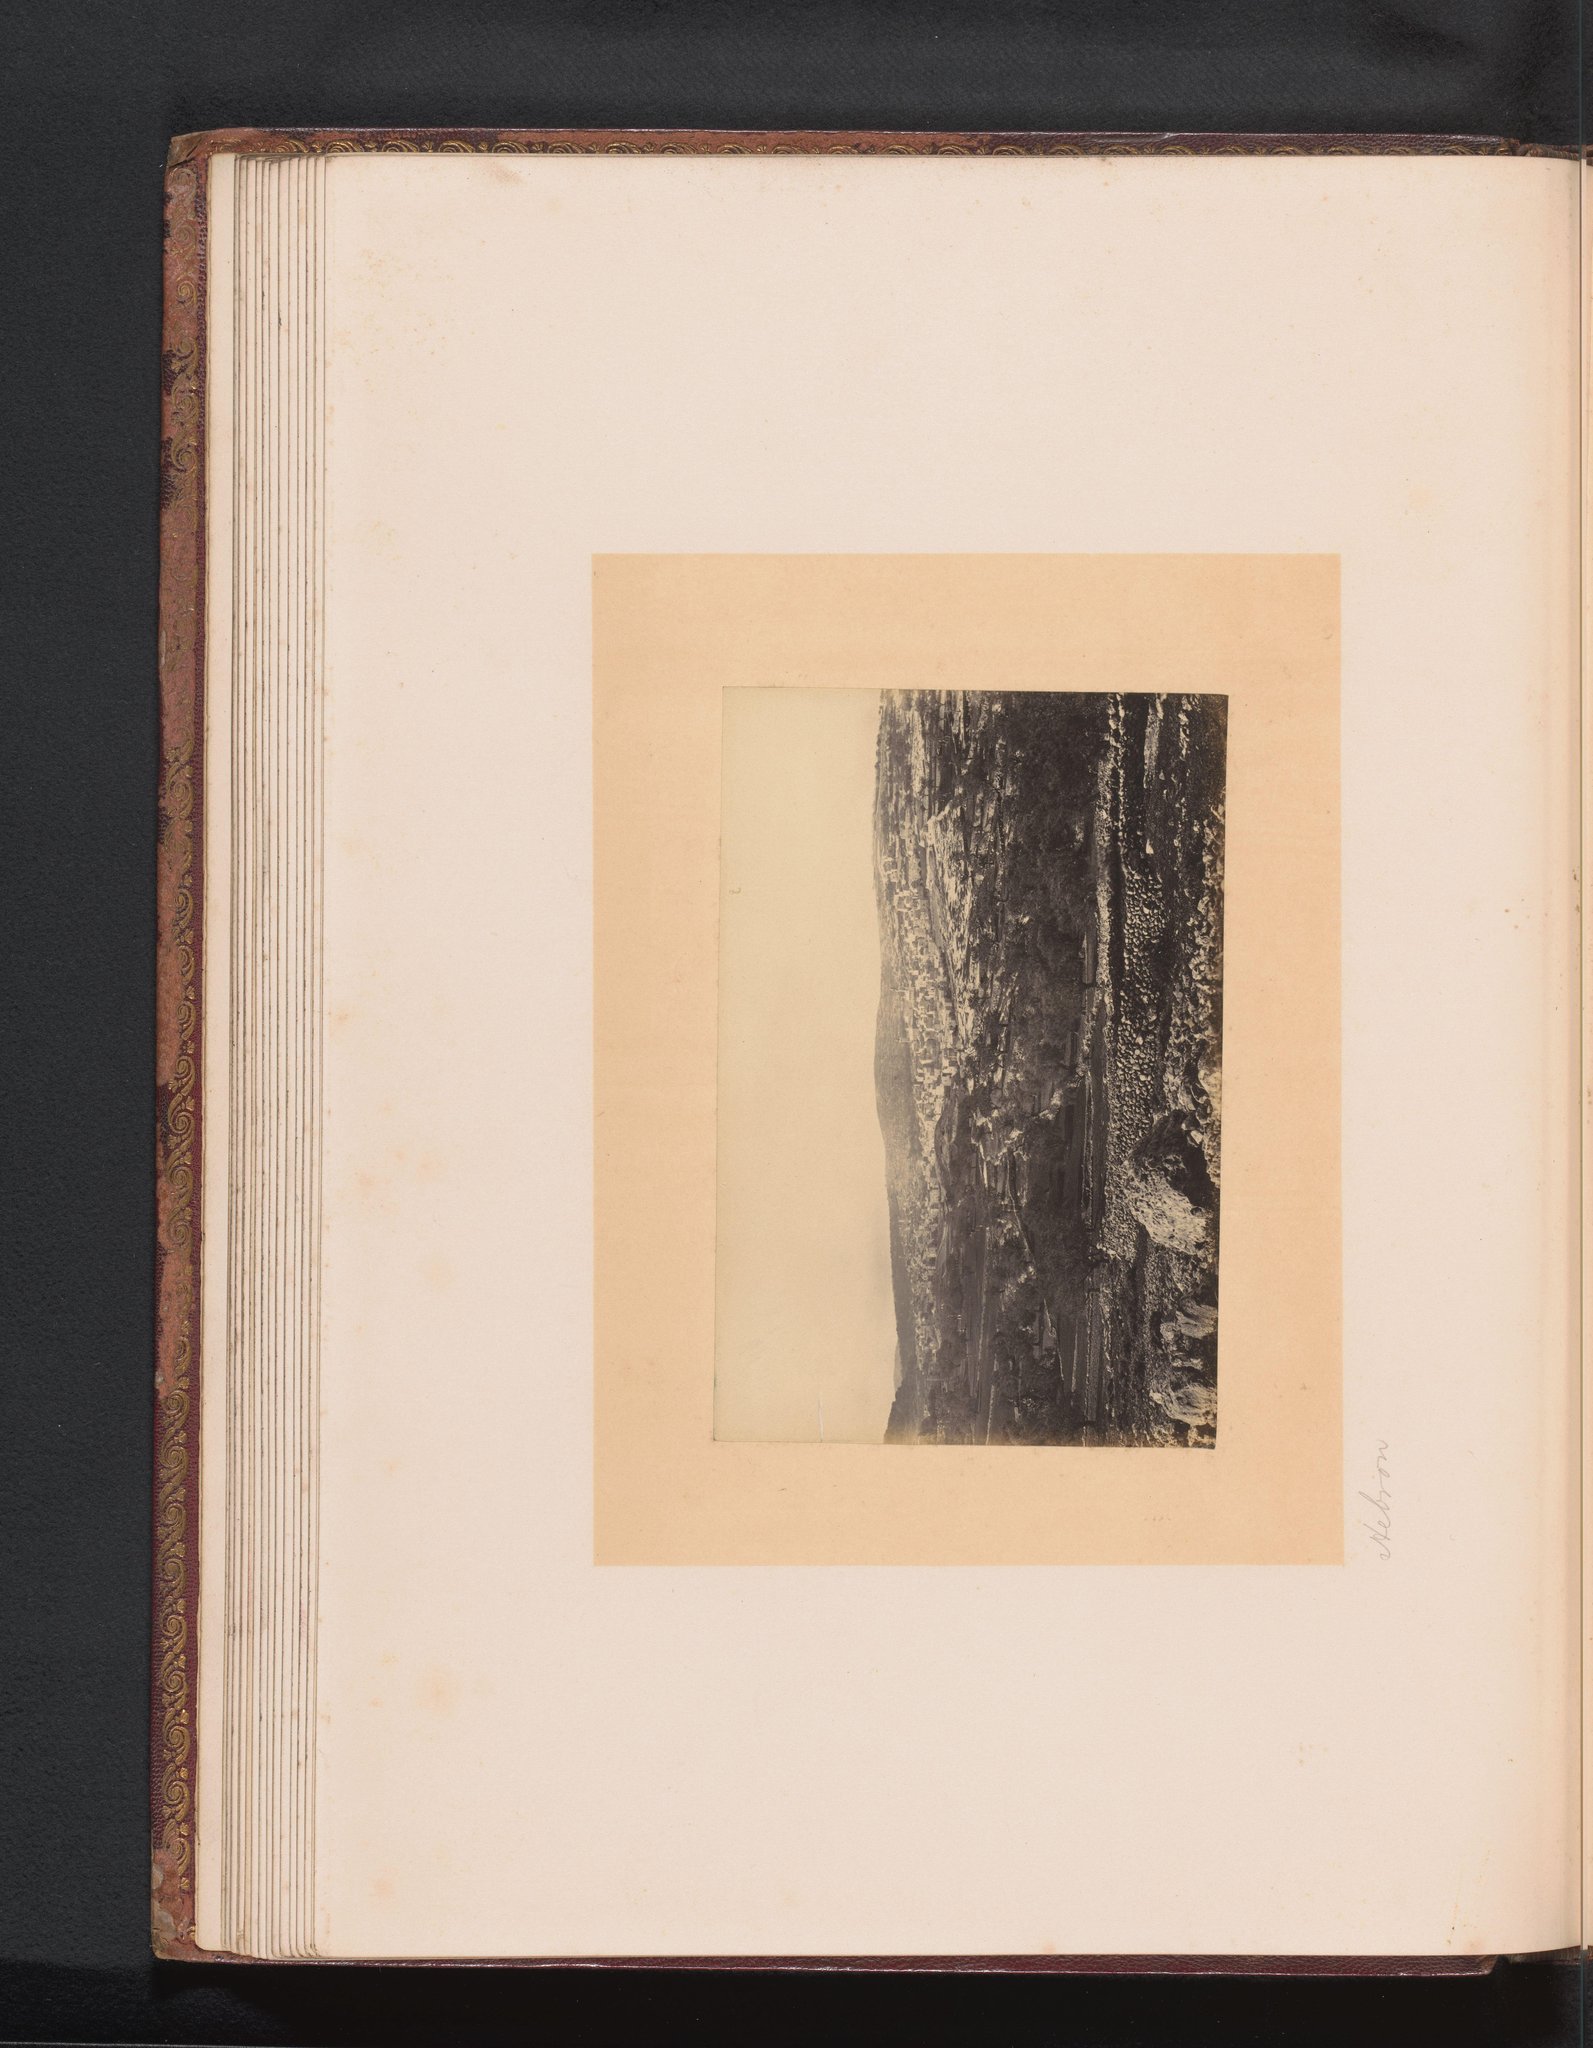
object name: page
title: Gezicht op Hebron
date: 1870-1875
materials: photographic support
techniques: albumen print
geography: hebron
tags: city-view in general; 'veduta'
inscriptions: annotation: ‘Hebron’